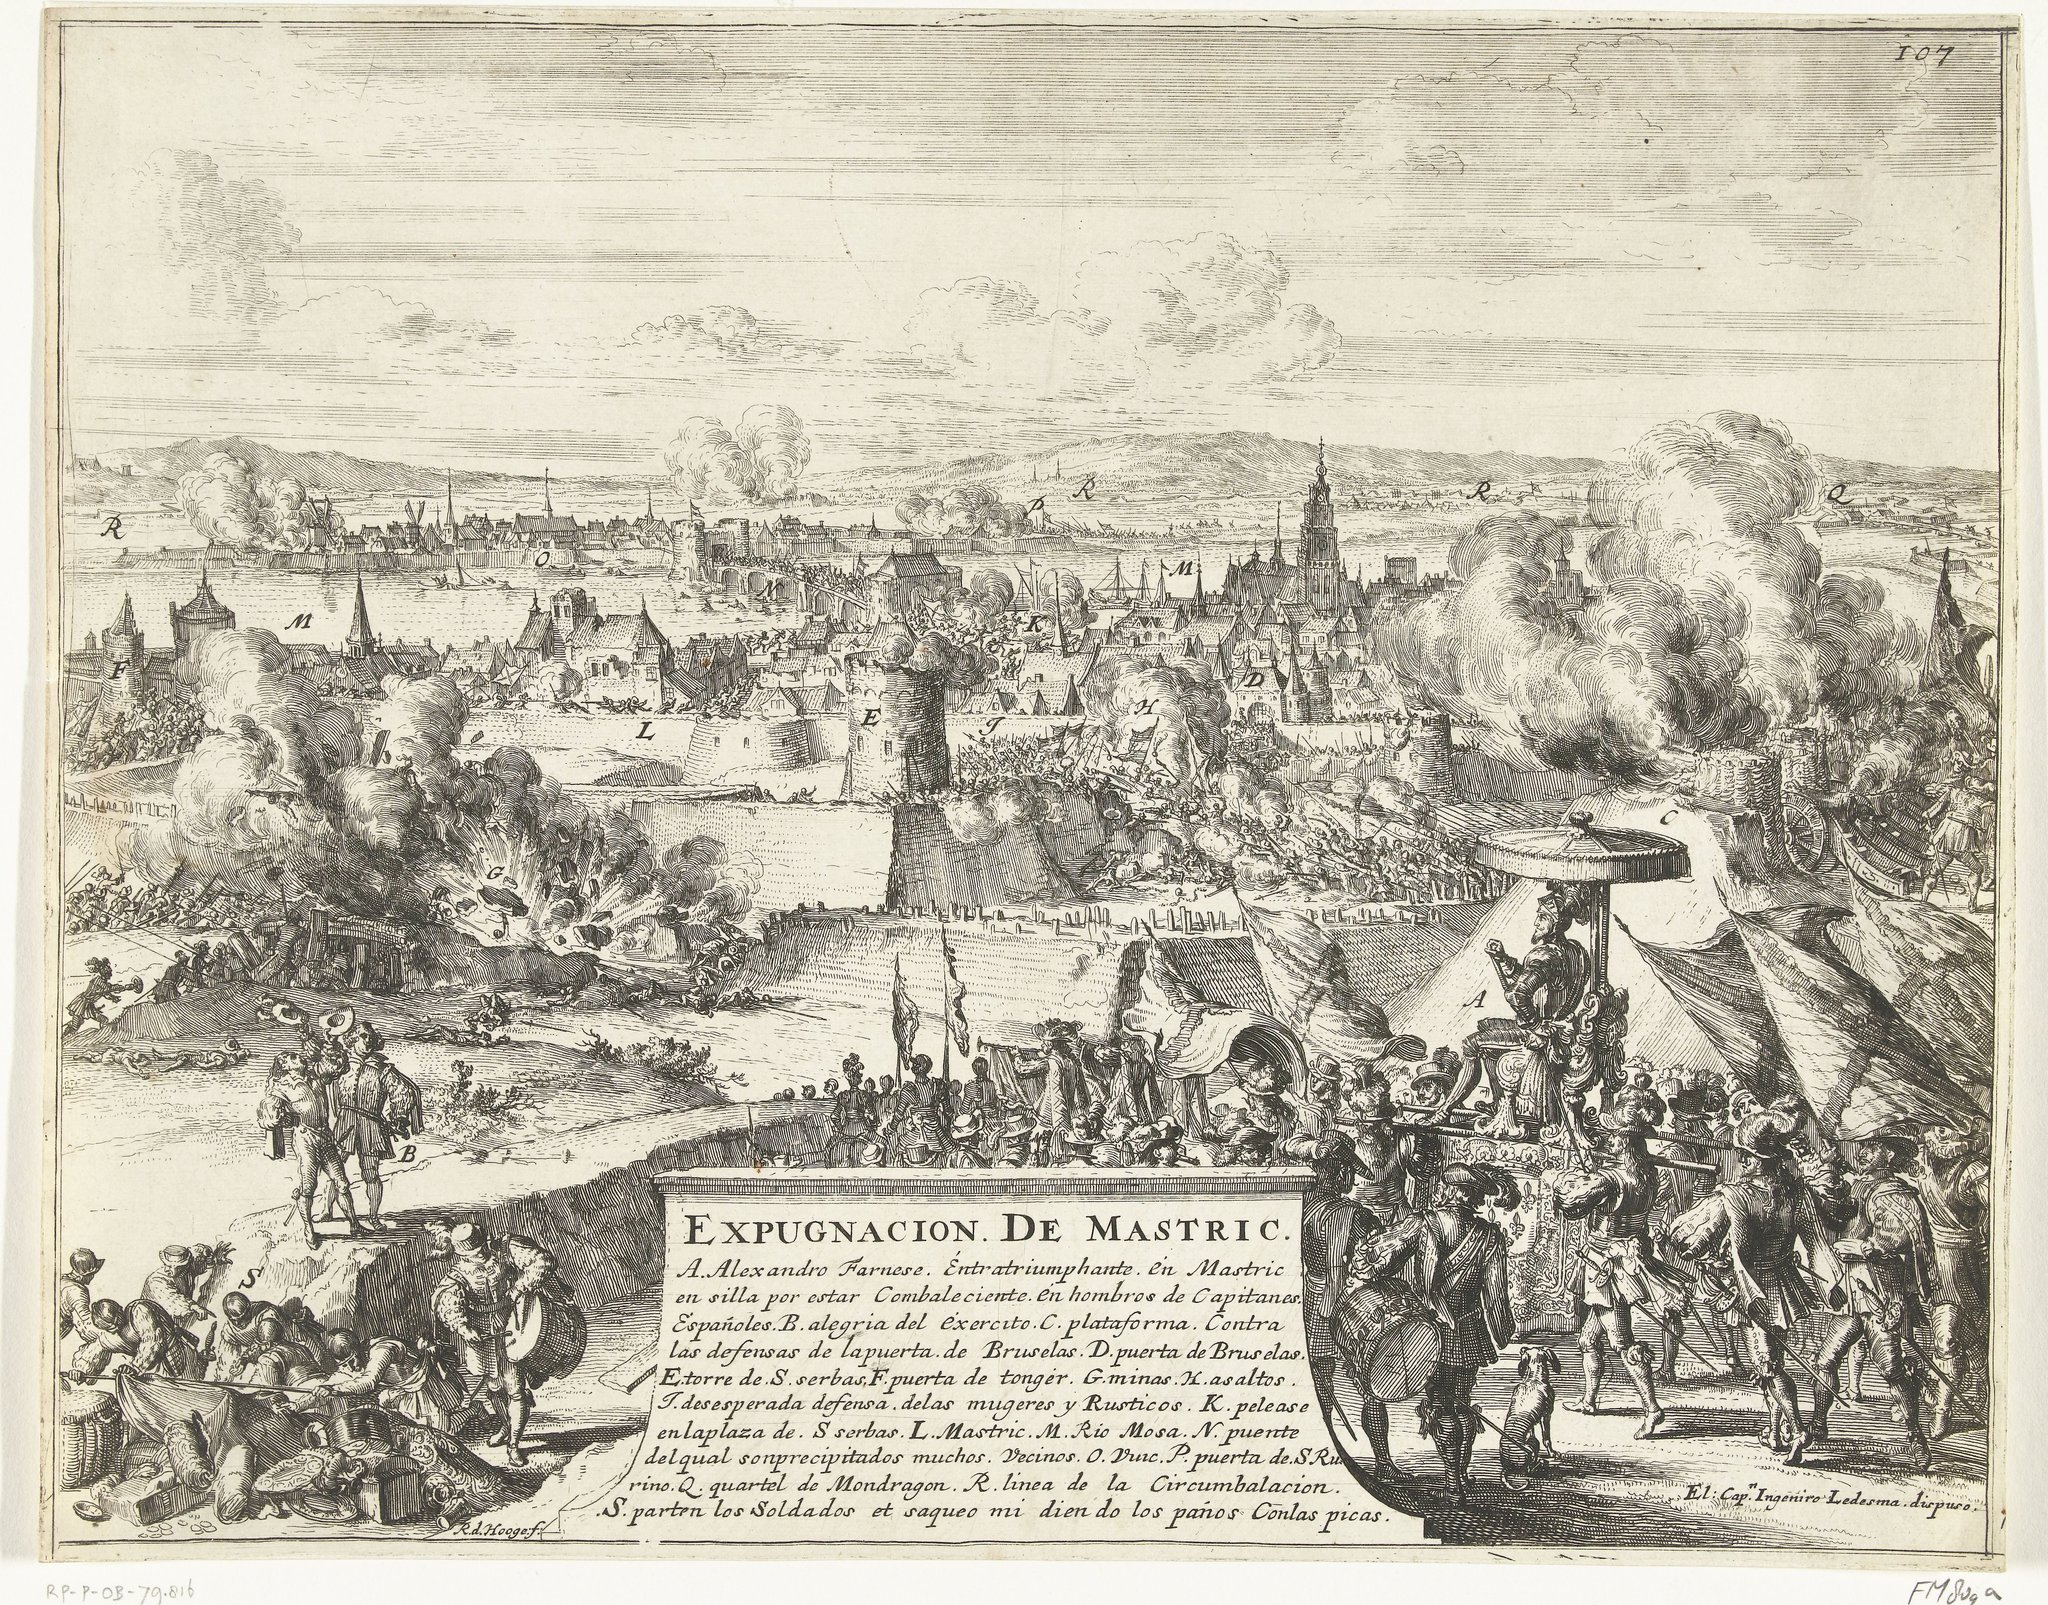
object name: history print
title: Inname van Maastricht door de hertog van Parma, 1579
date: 1670-1699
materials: paper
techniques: etching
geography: northern netherlands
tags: rome, alessandro farnese (landvoogd van de nederlanden en hertog van parma en piacenza), (carrying a person in a) sedan-chair, capture of city (after the siege), maastricht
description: Inname van Maastricht door het leger van de hertog van Parma, 29 juni 1579. Farnese wordt zittend op een stoel onder een parasol de stad binnengedragen. Middenonder een cartouche met de titel en de legenda A-S in het Spaans.